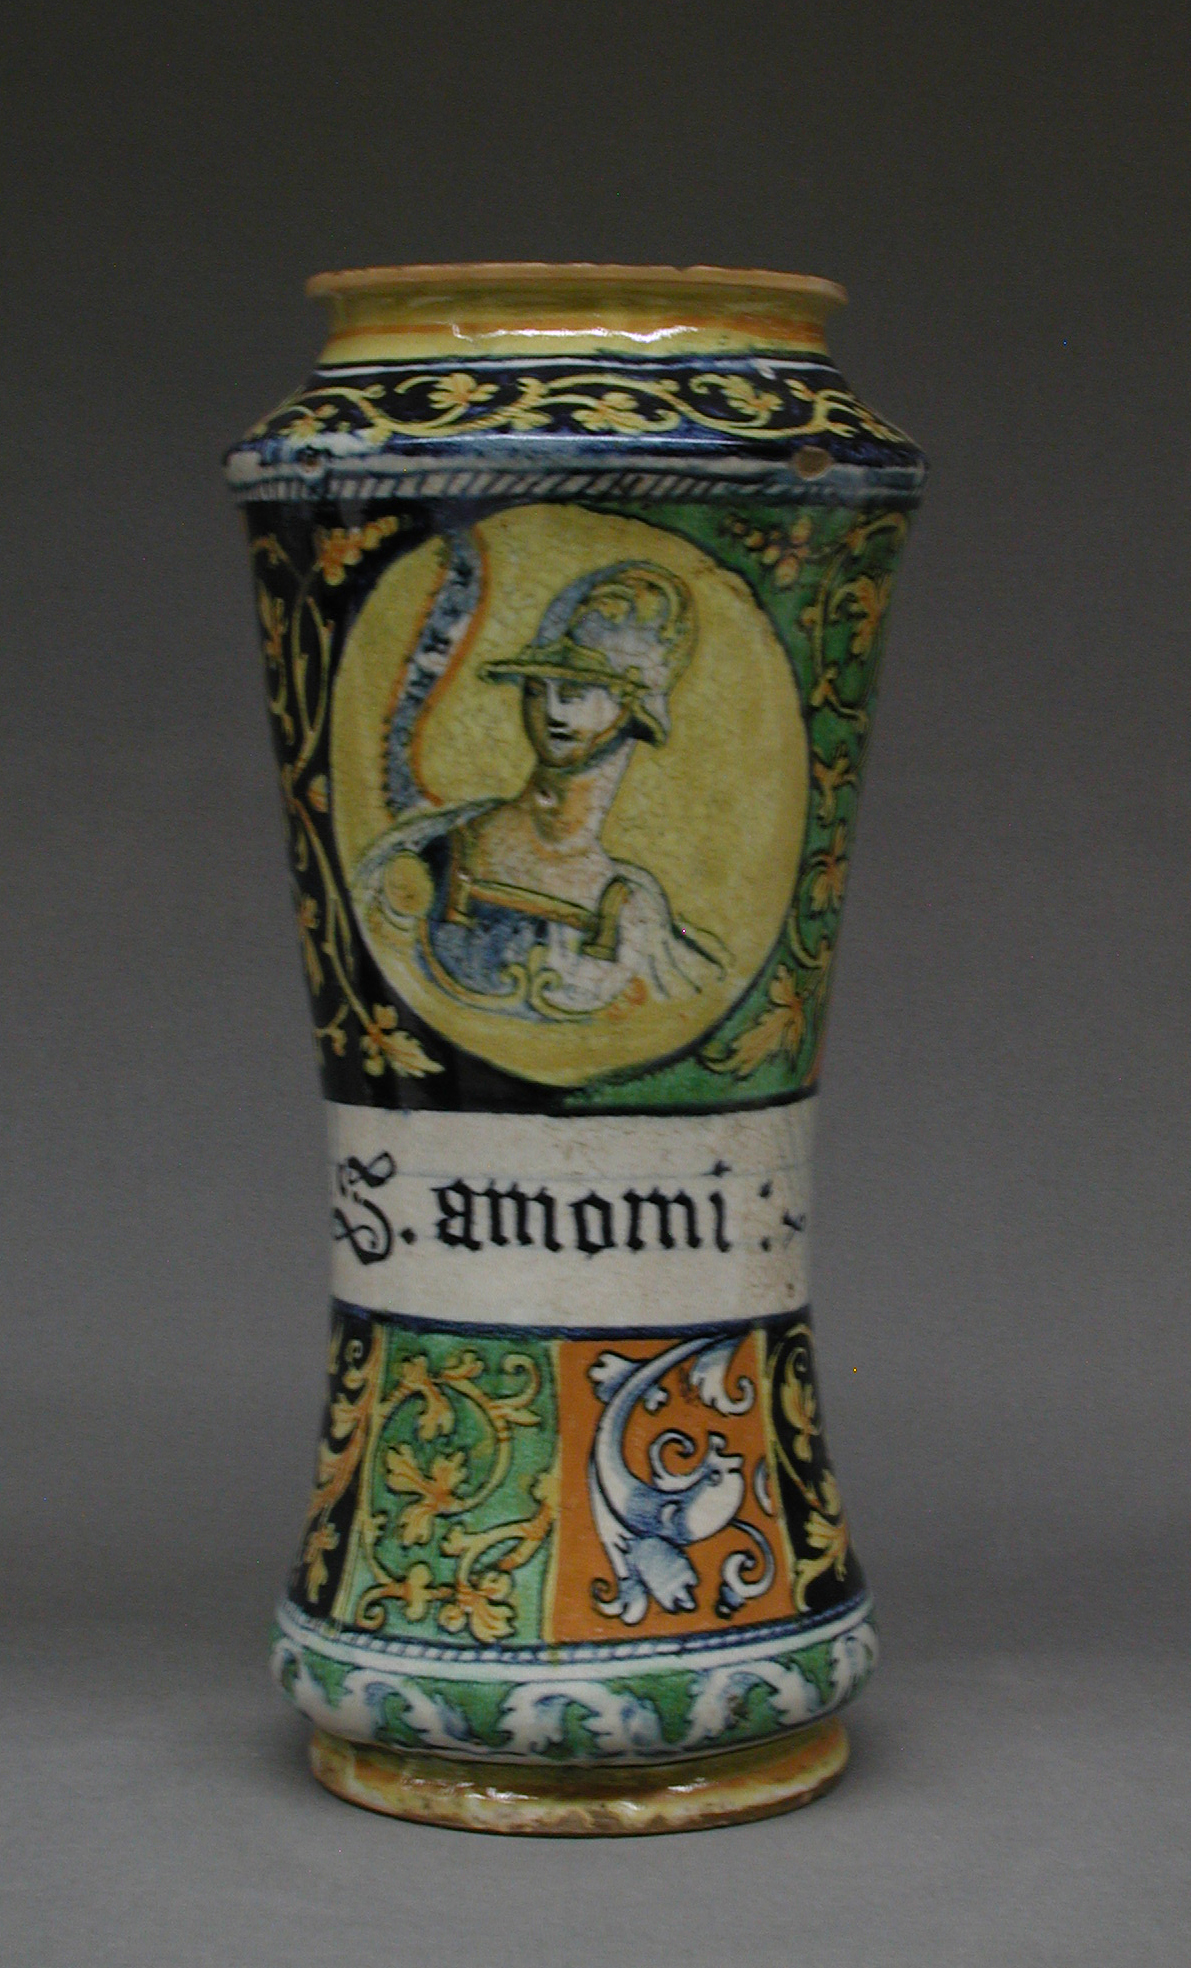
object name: albarello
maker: lazzaro workshop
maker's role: maker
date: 1551-1600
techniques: maiolica, glazing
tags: men,portraits